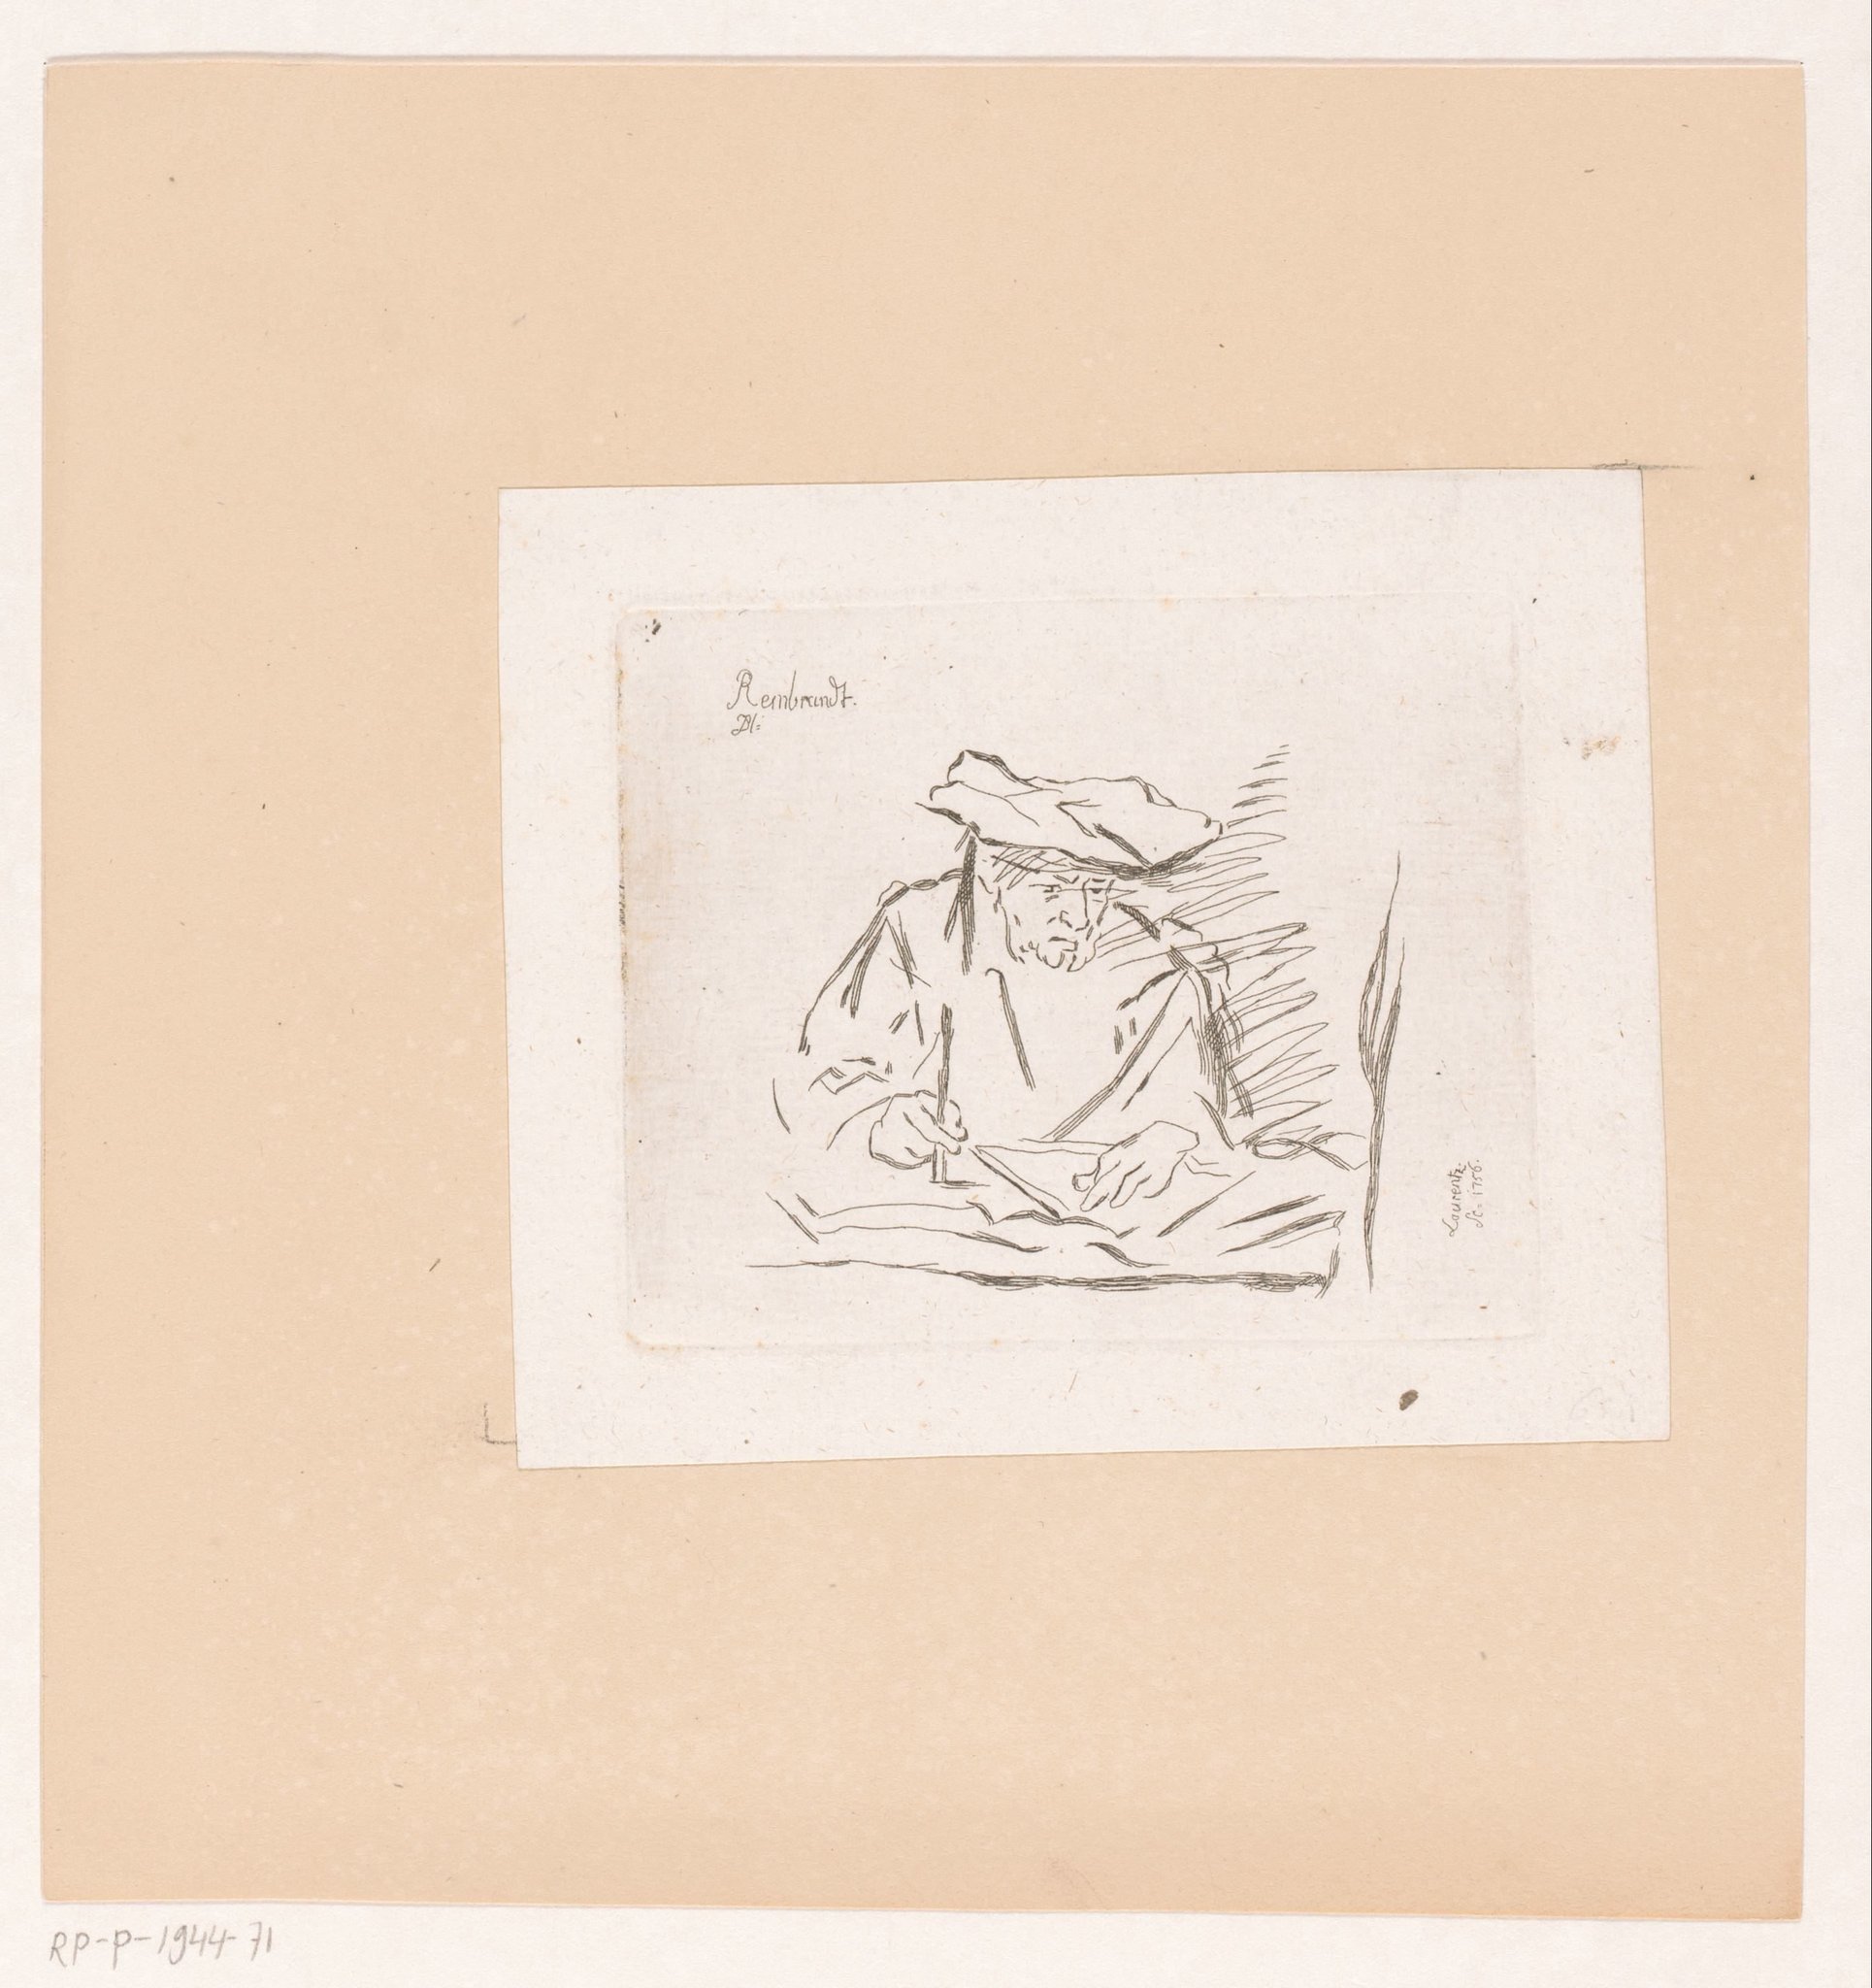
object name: print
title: Schrijvende oude man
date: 1756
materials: paper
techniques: etching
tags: handwriting, writing as activity, old man, head-gear: hat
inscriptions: collector's mark: Lugt 240, collector's mark: Lugt 2228